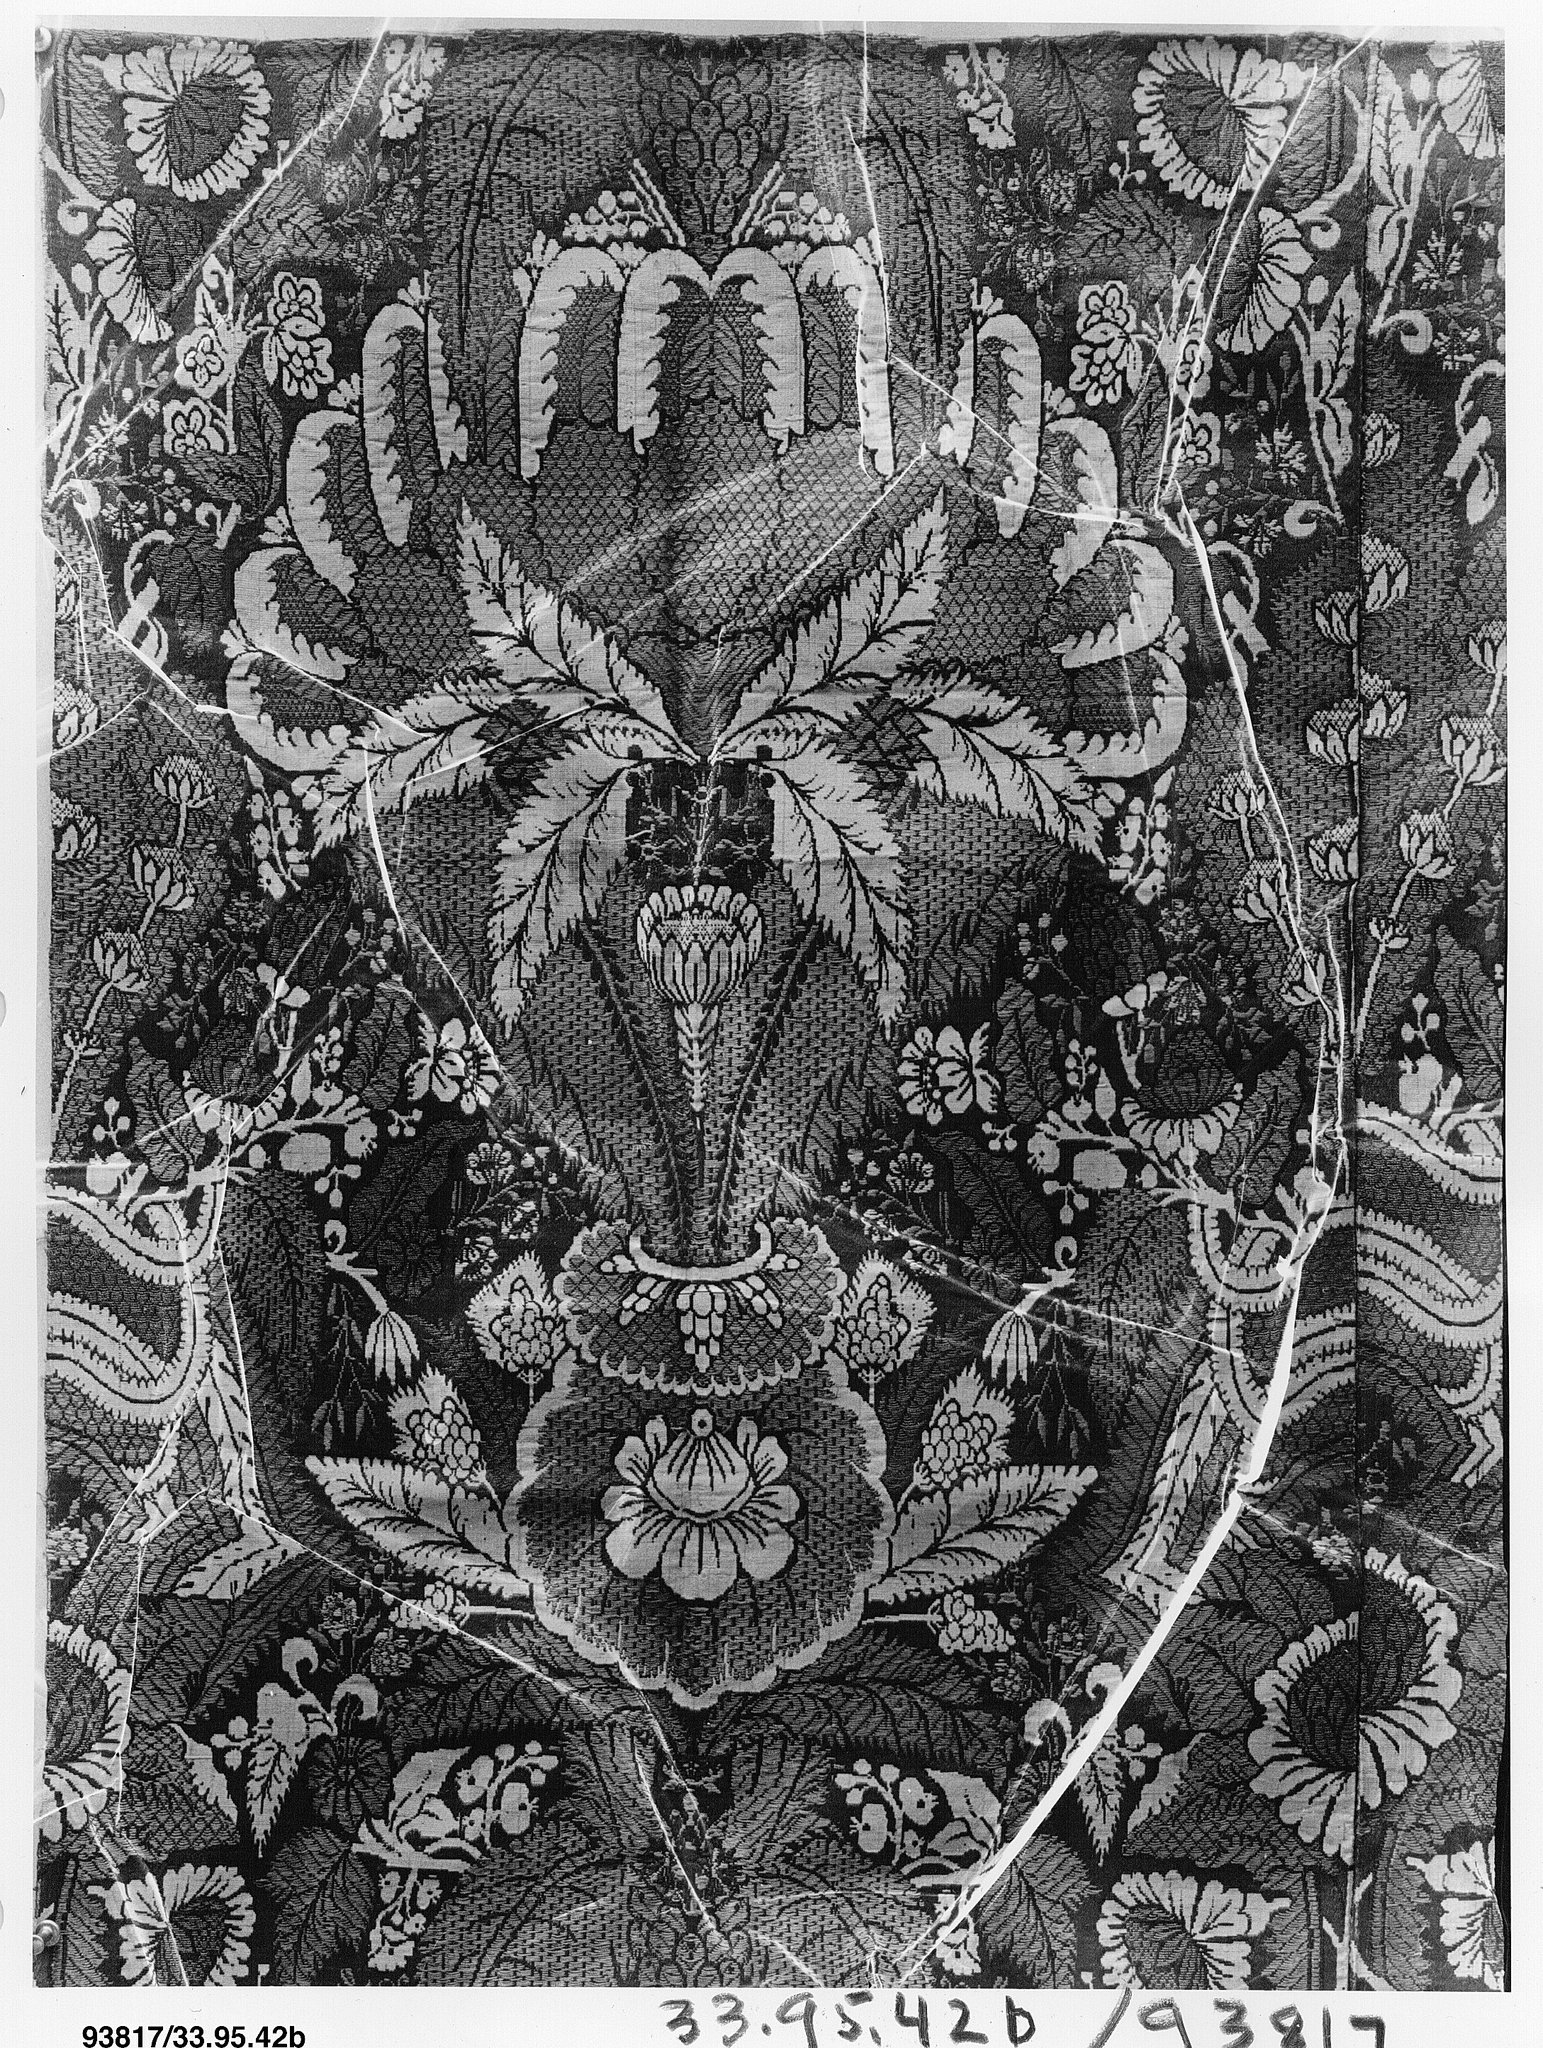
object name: fragment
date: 1801-1900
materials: metal thread, silk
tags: leaves